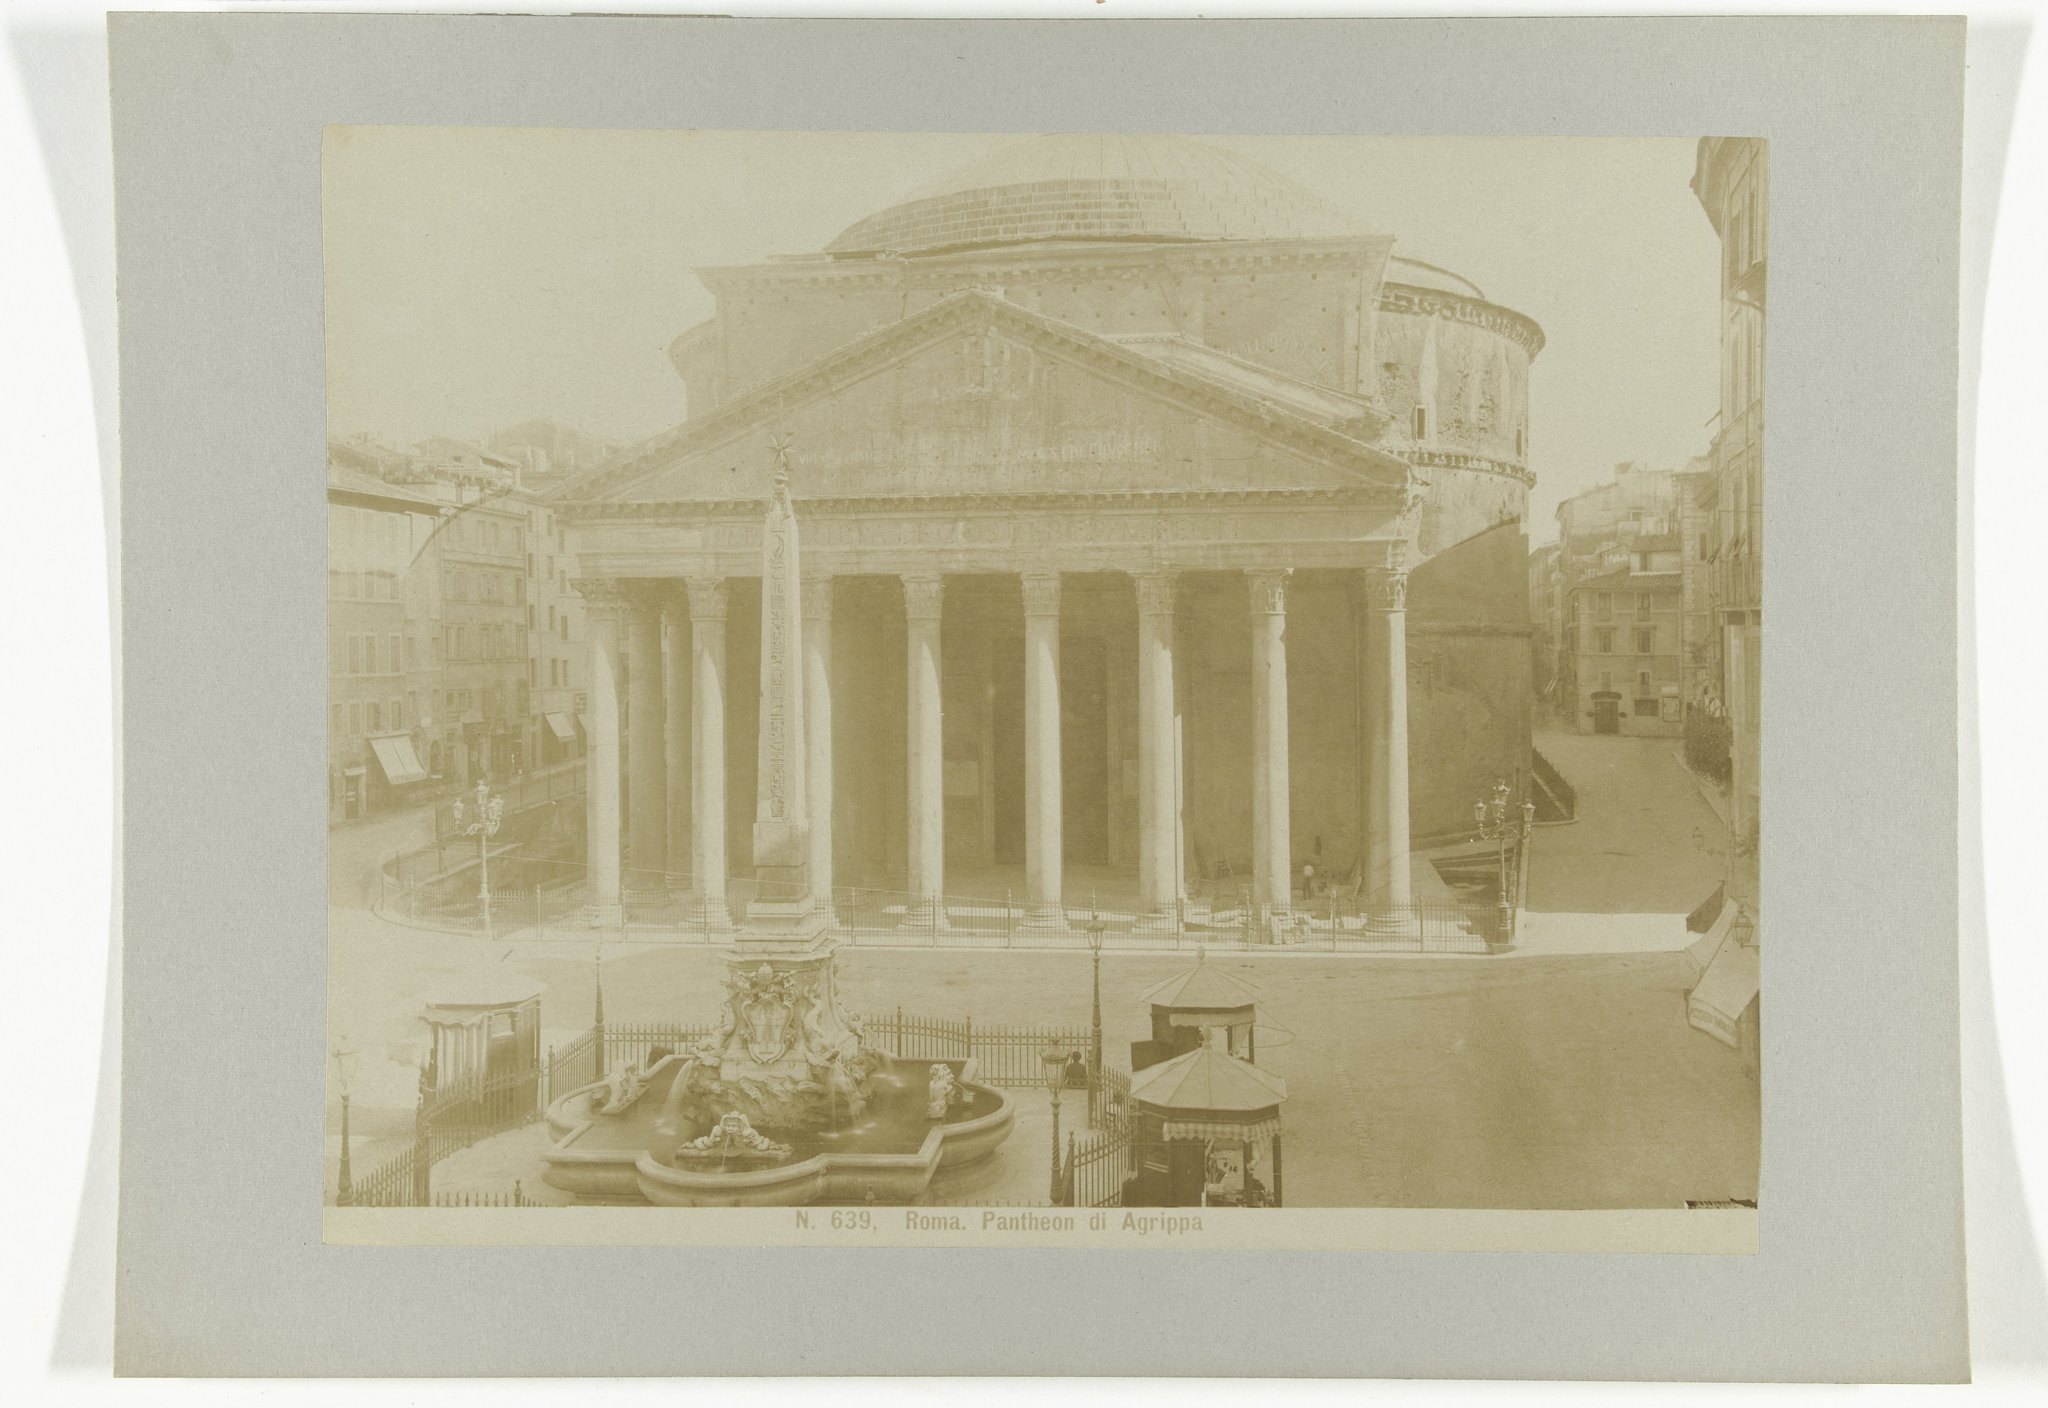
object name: photograph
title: N. 639, Roma. Pantheon di Agrippa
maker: Anonymous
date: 1880-1904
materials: cardboard, paper, photographic support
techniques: albumen print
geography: rome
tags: pantheon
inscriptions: number: ‘32.’